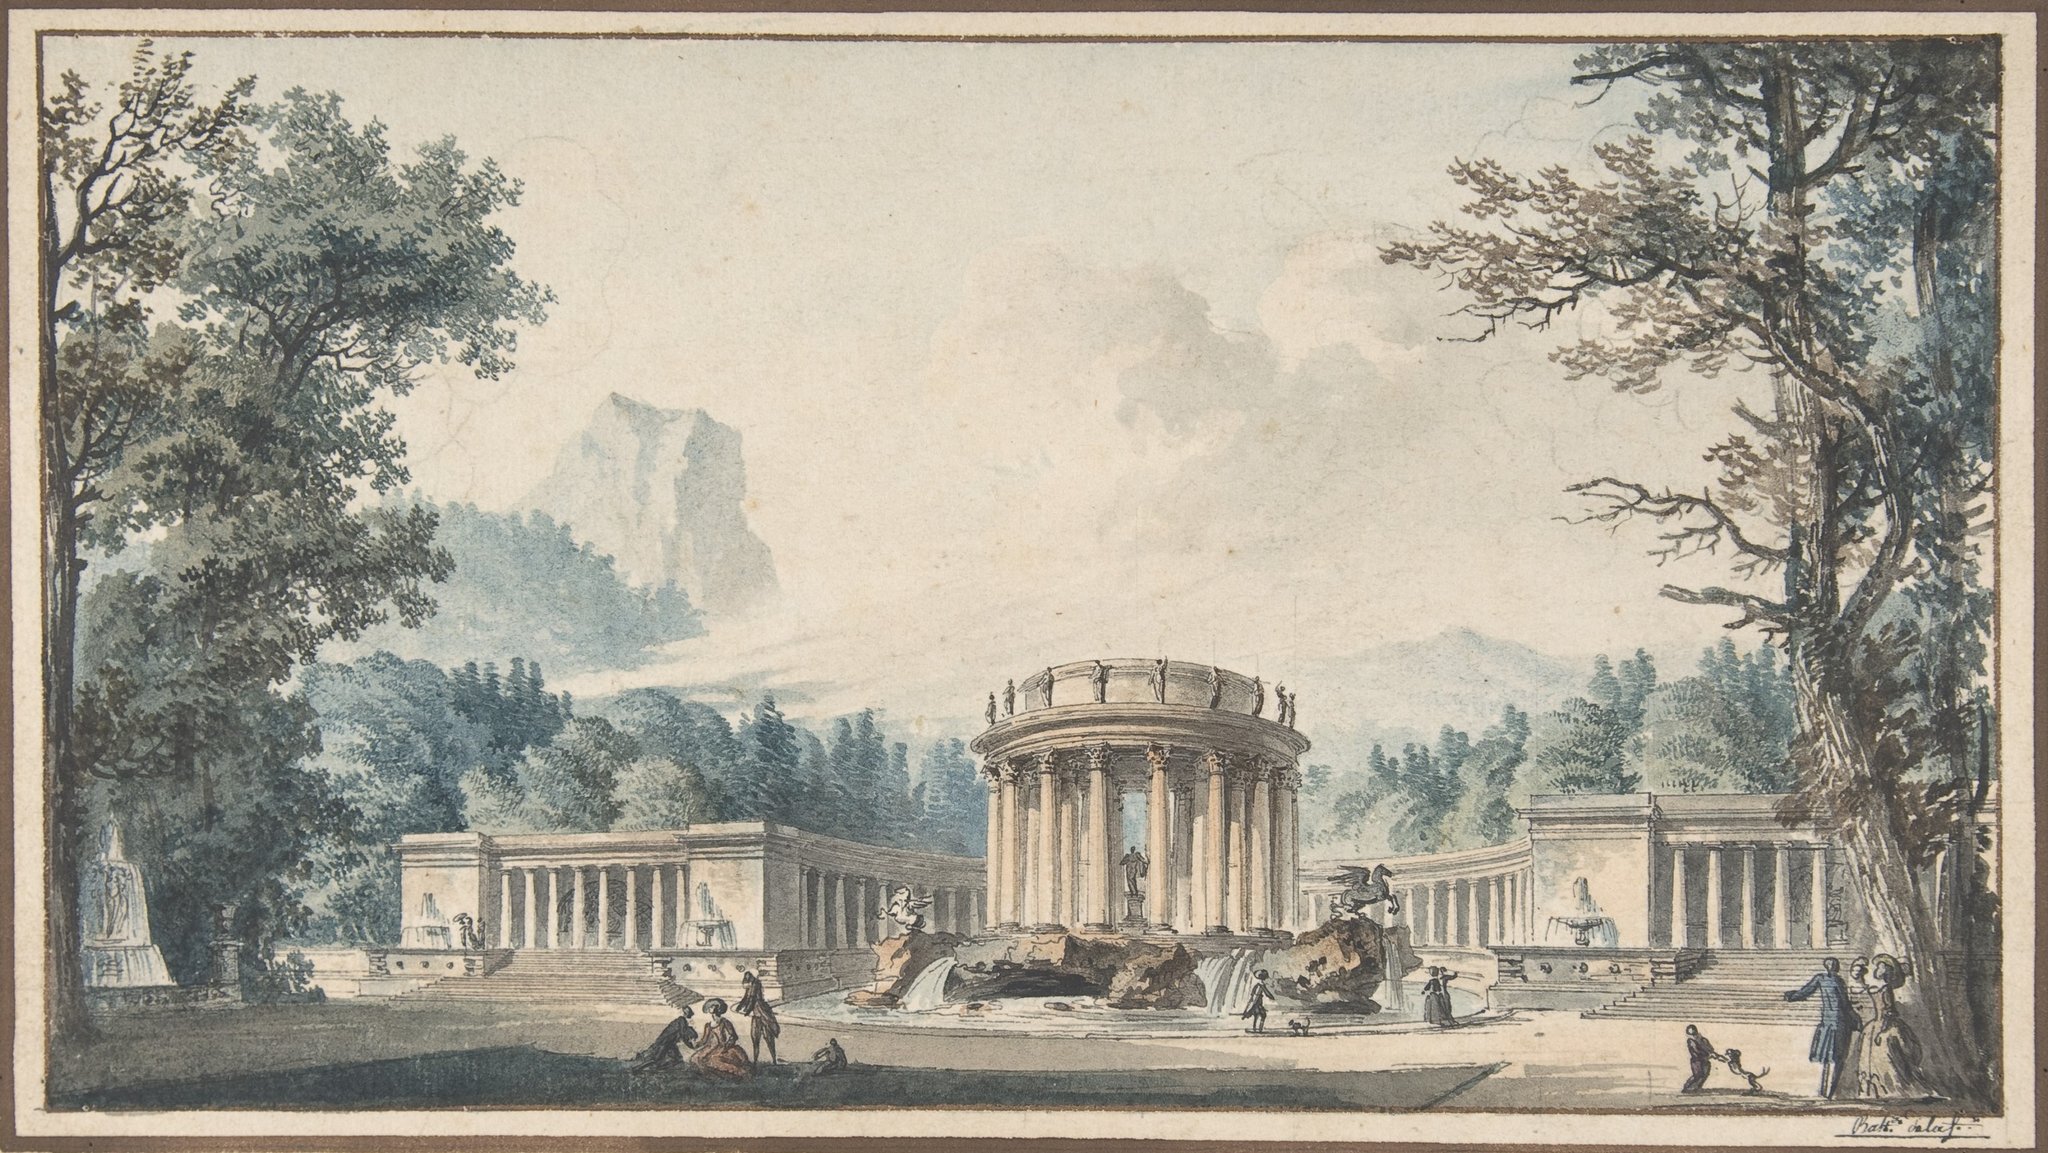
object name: drawing ornament architecture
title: Project for a Fête Decor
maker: louis pierre baltard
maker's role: artist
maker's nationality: french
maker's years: 1764-1846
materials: chalk, ink, watercolor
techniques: pen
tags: buildings,landscapes